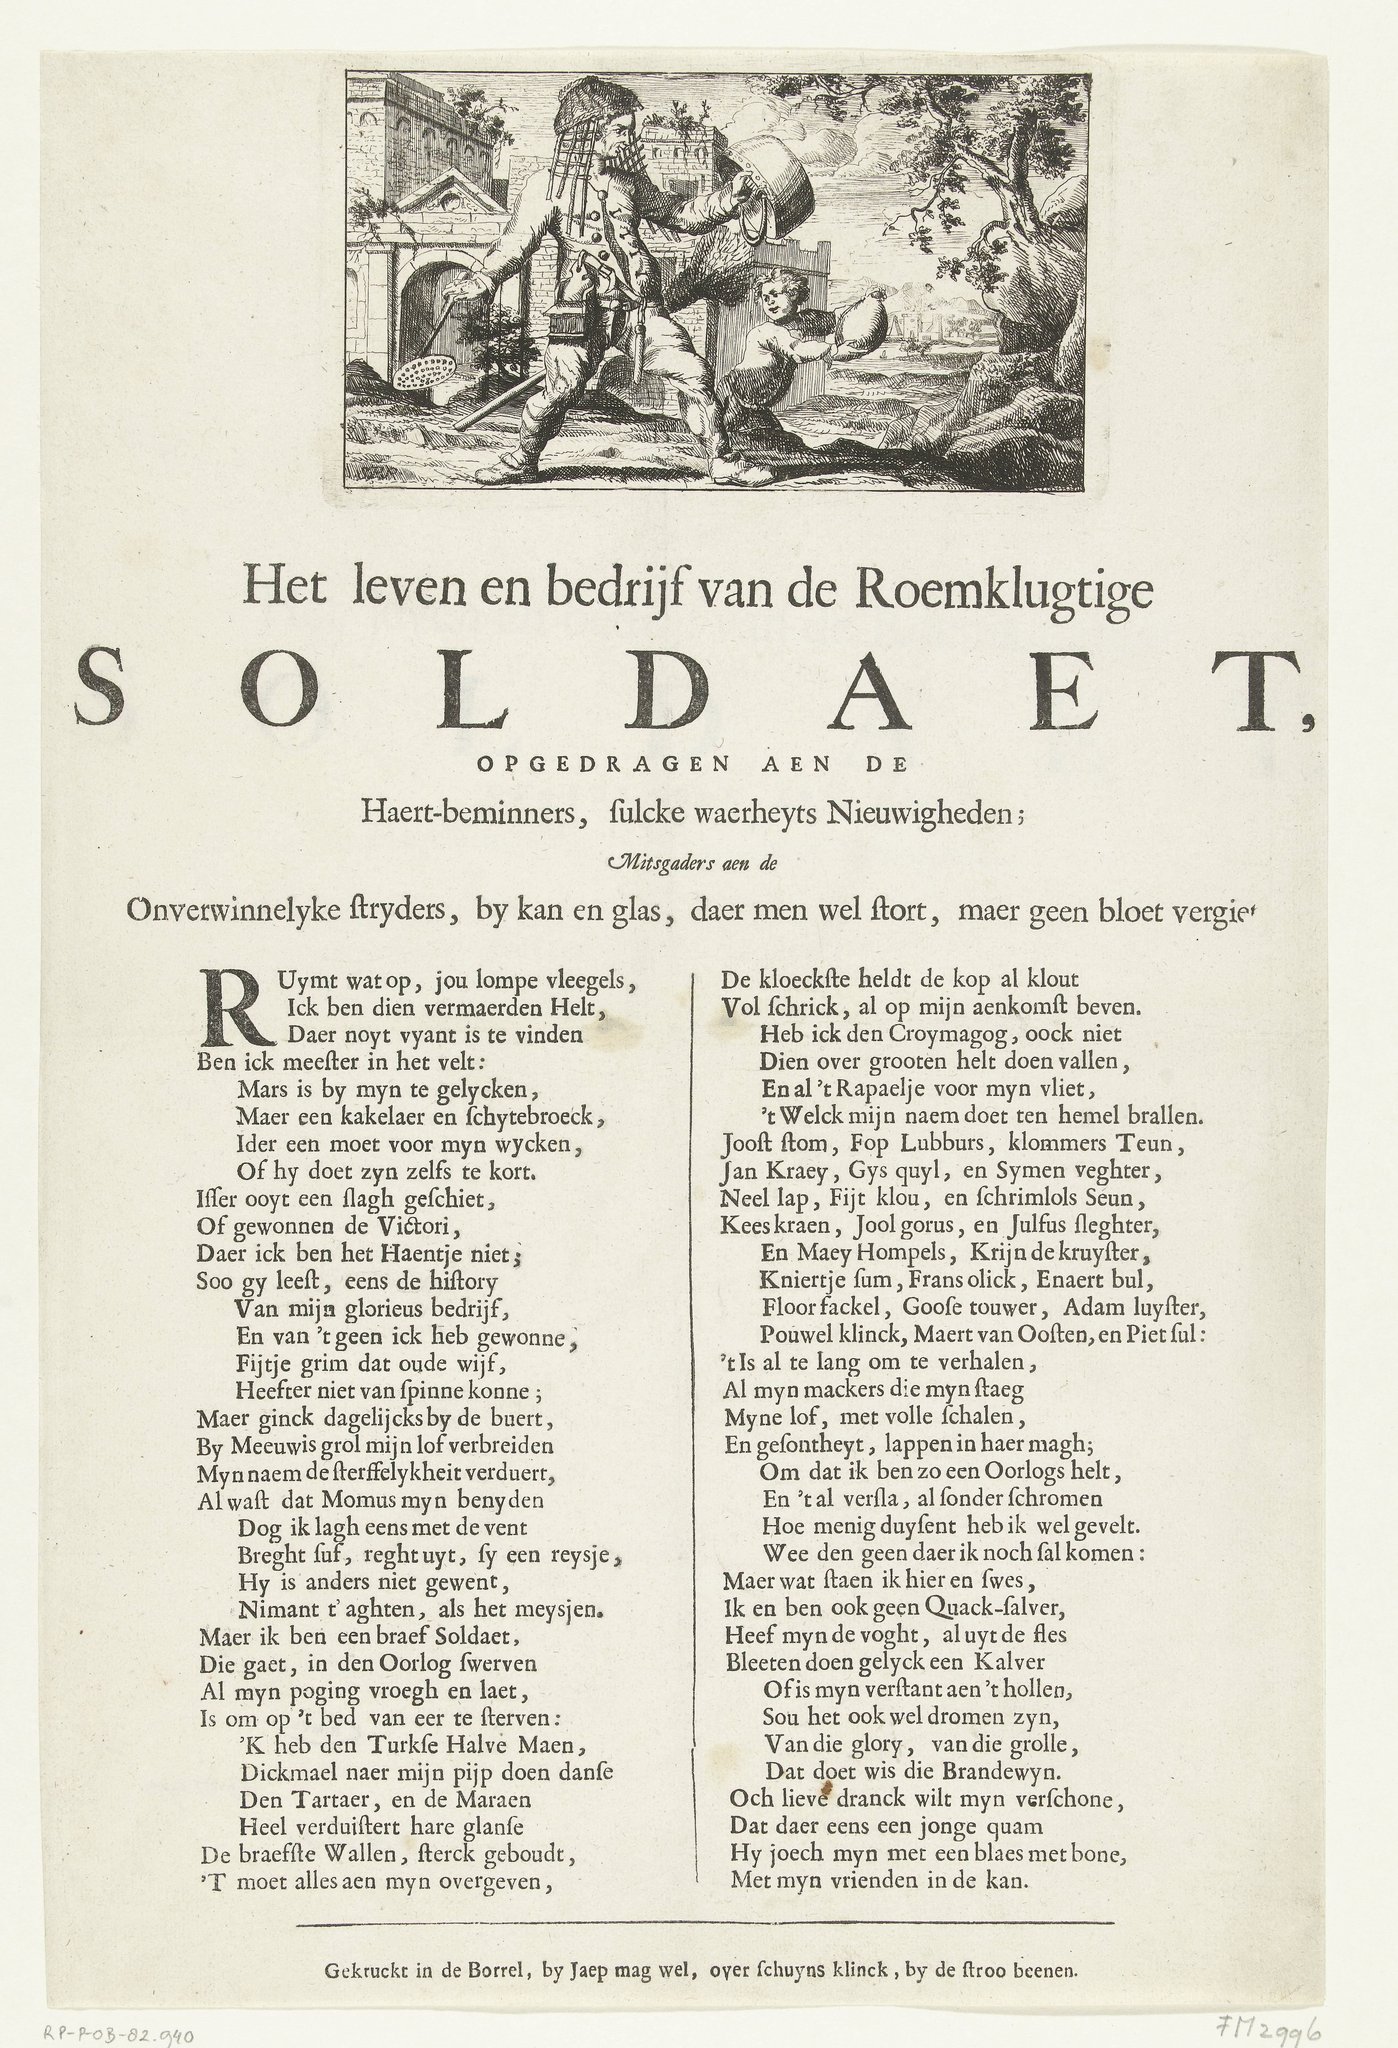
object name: print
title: Spotprent op de drankzuchtige soldaat, ca. 1700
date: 1690-1710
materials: paper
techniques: etching, letterpress printing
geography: northern netherlands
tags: drunkard, the soldier off duty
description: Spotprent op de drankzuchtige soldaat. Dronken soldaat bewapend met schuimspaan en ketel en met een mand op het hoofd. Onder de plaat een vers in twee kolommen.